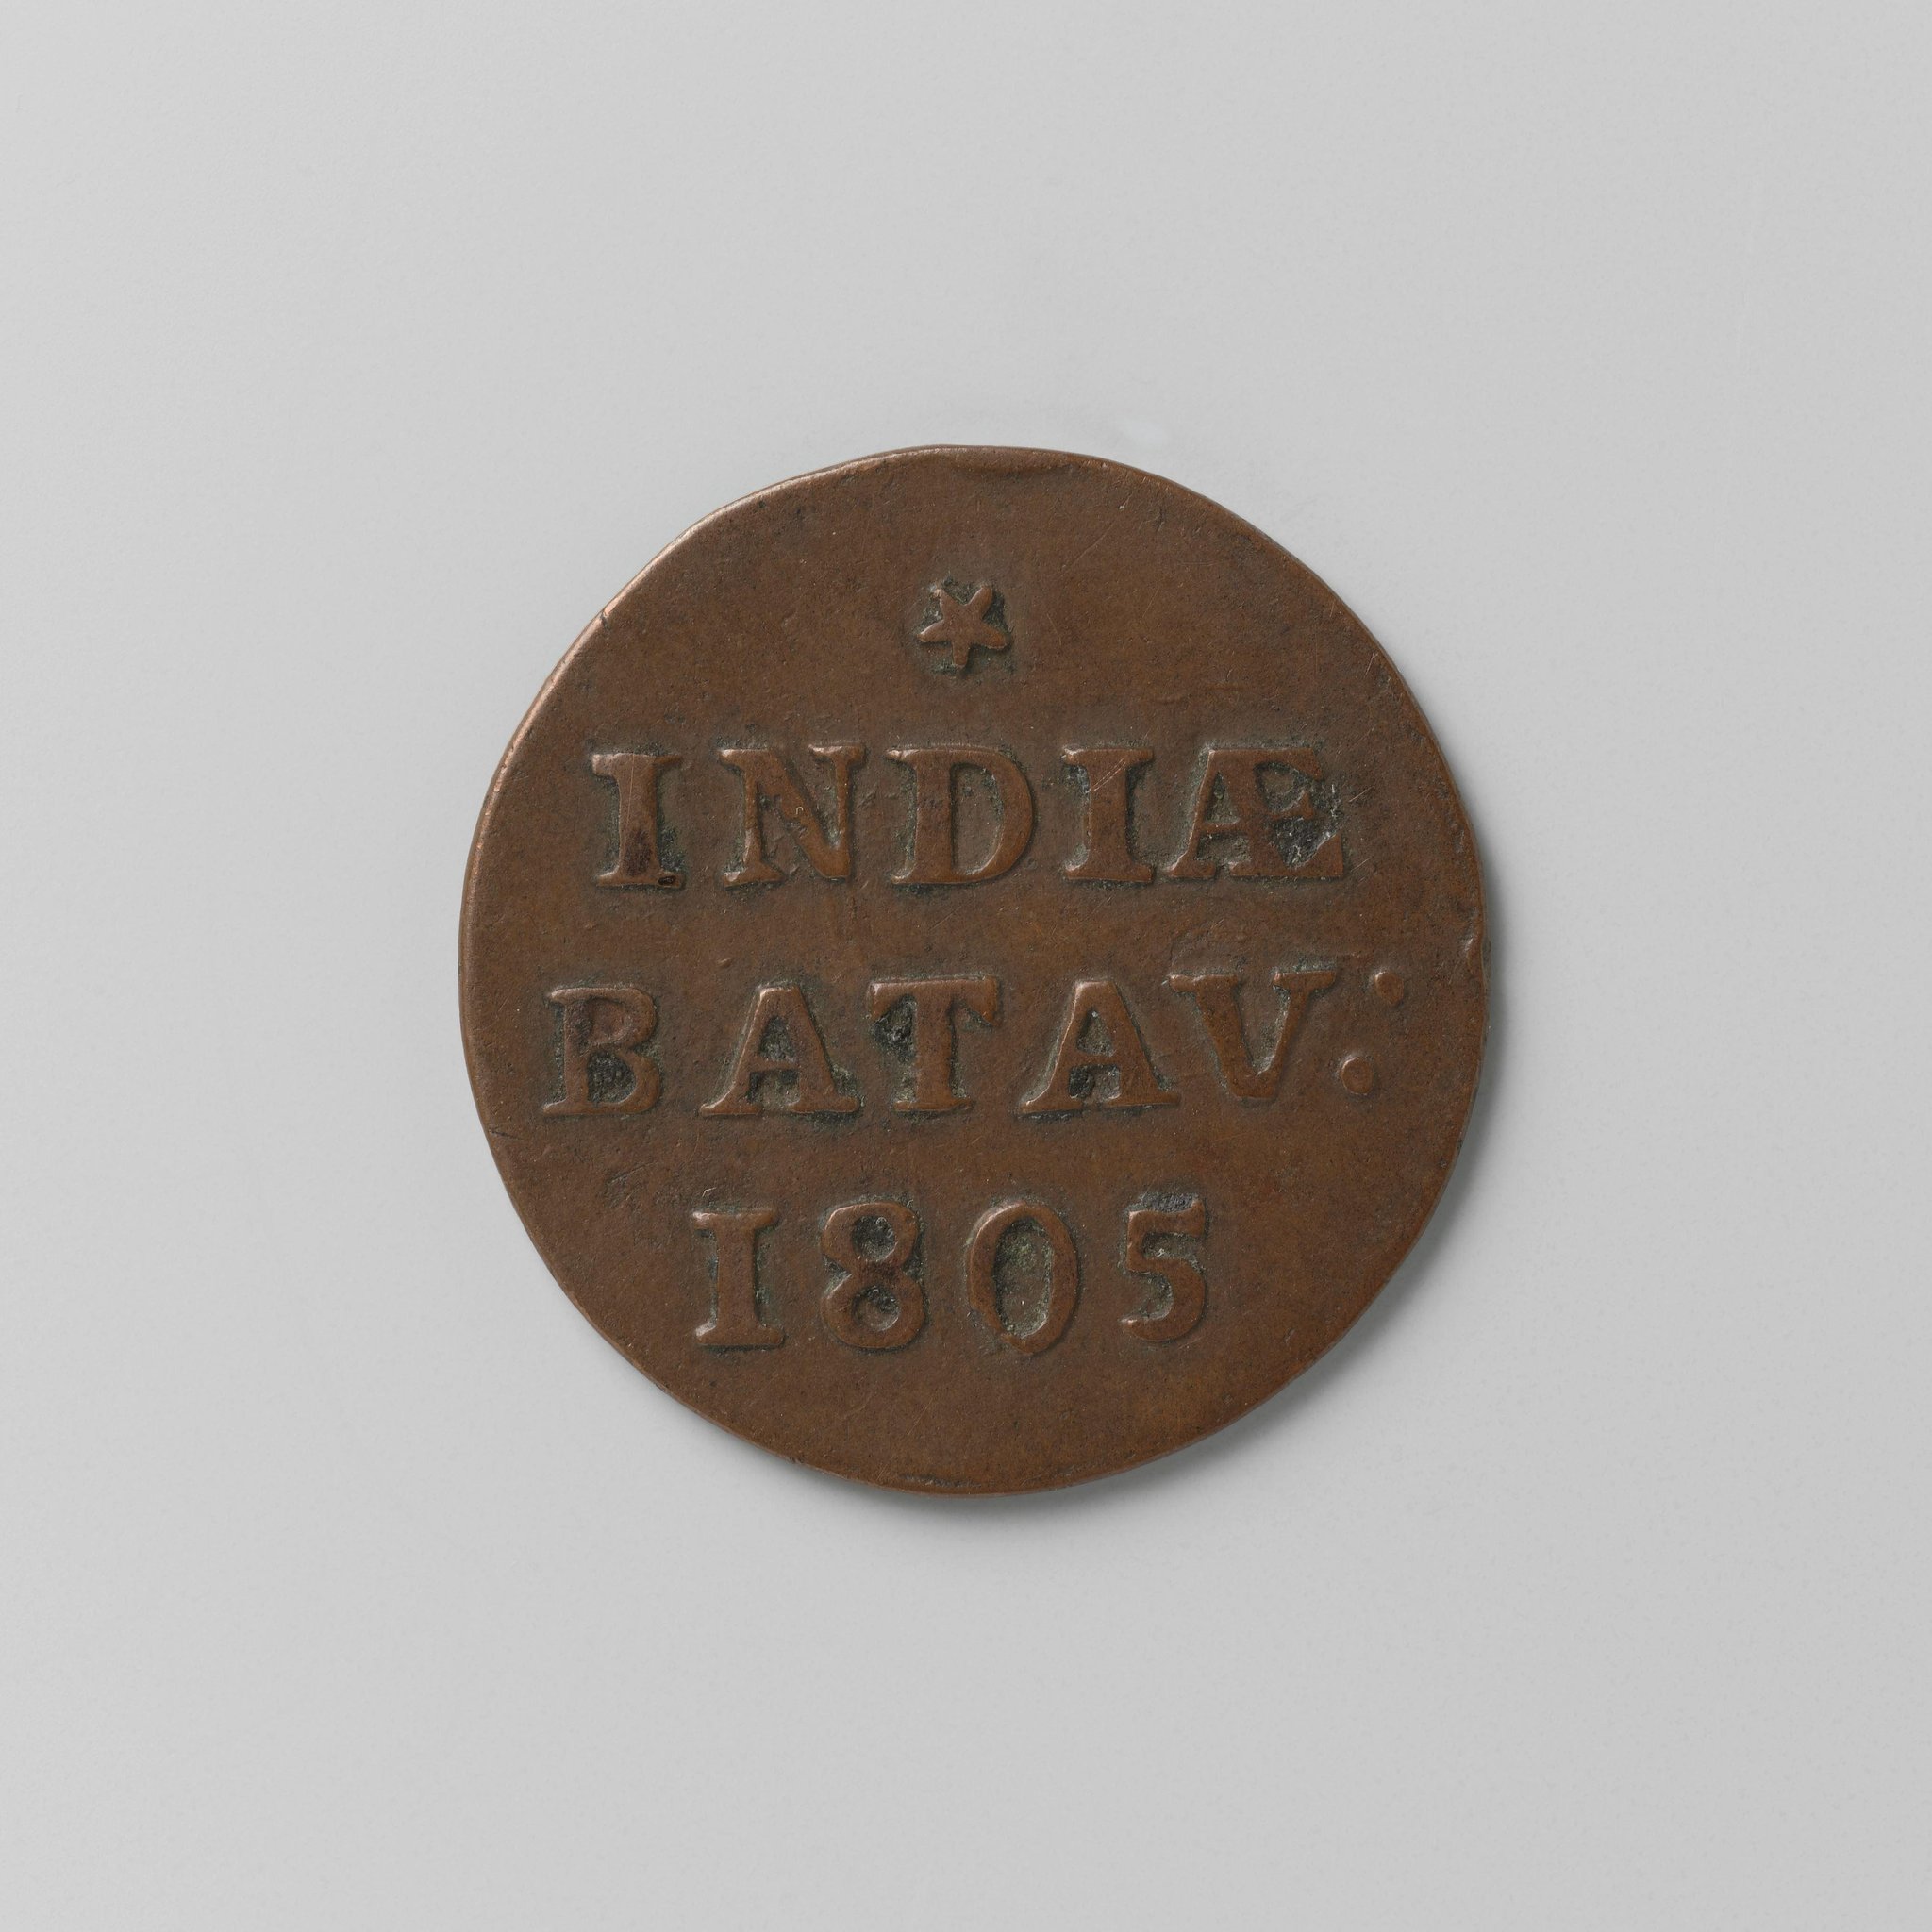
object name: coin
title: Duit voor Nederlands Indië uit Holland,1805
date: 1805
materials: copper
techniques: striking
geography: hoorn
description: Koperen munt. Voorzijde: tweeregelig opschrift, waarboven muntteken en waaronder jaartal. Keerzijde: tussen waarde-aanduiding 5 1/16 G gekroond generaliteitswapenschild. Gladde rand.